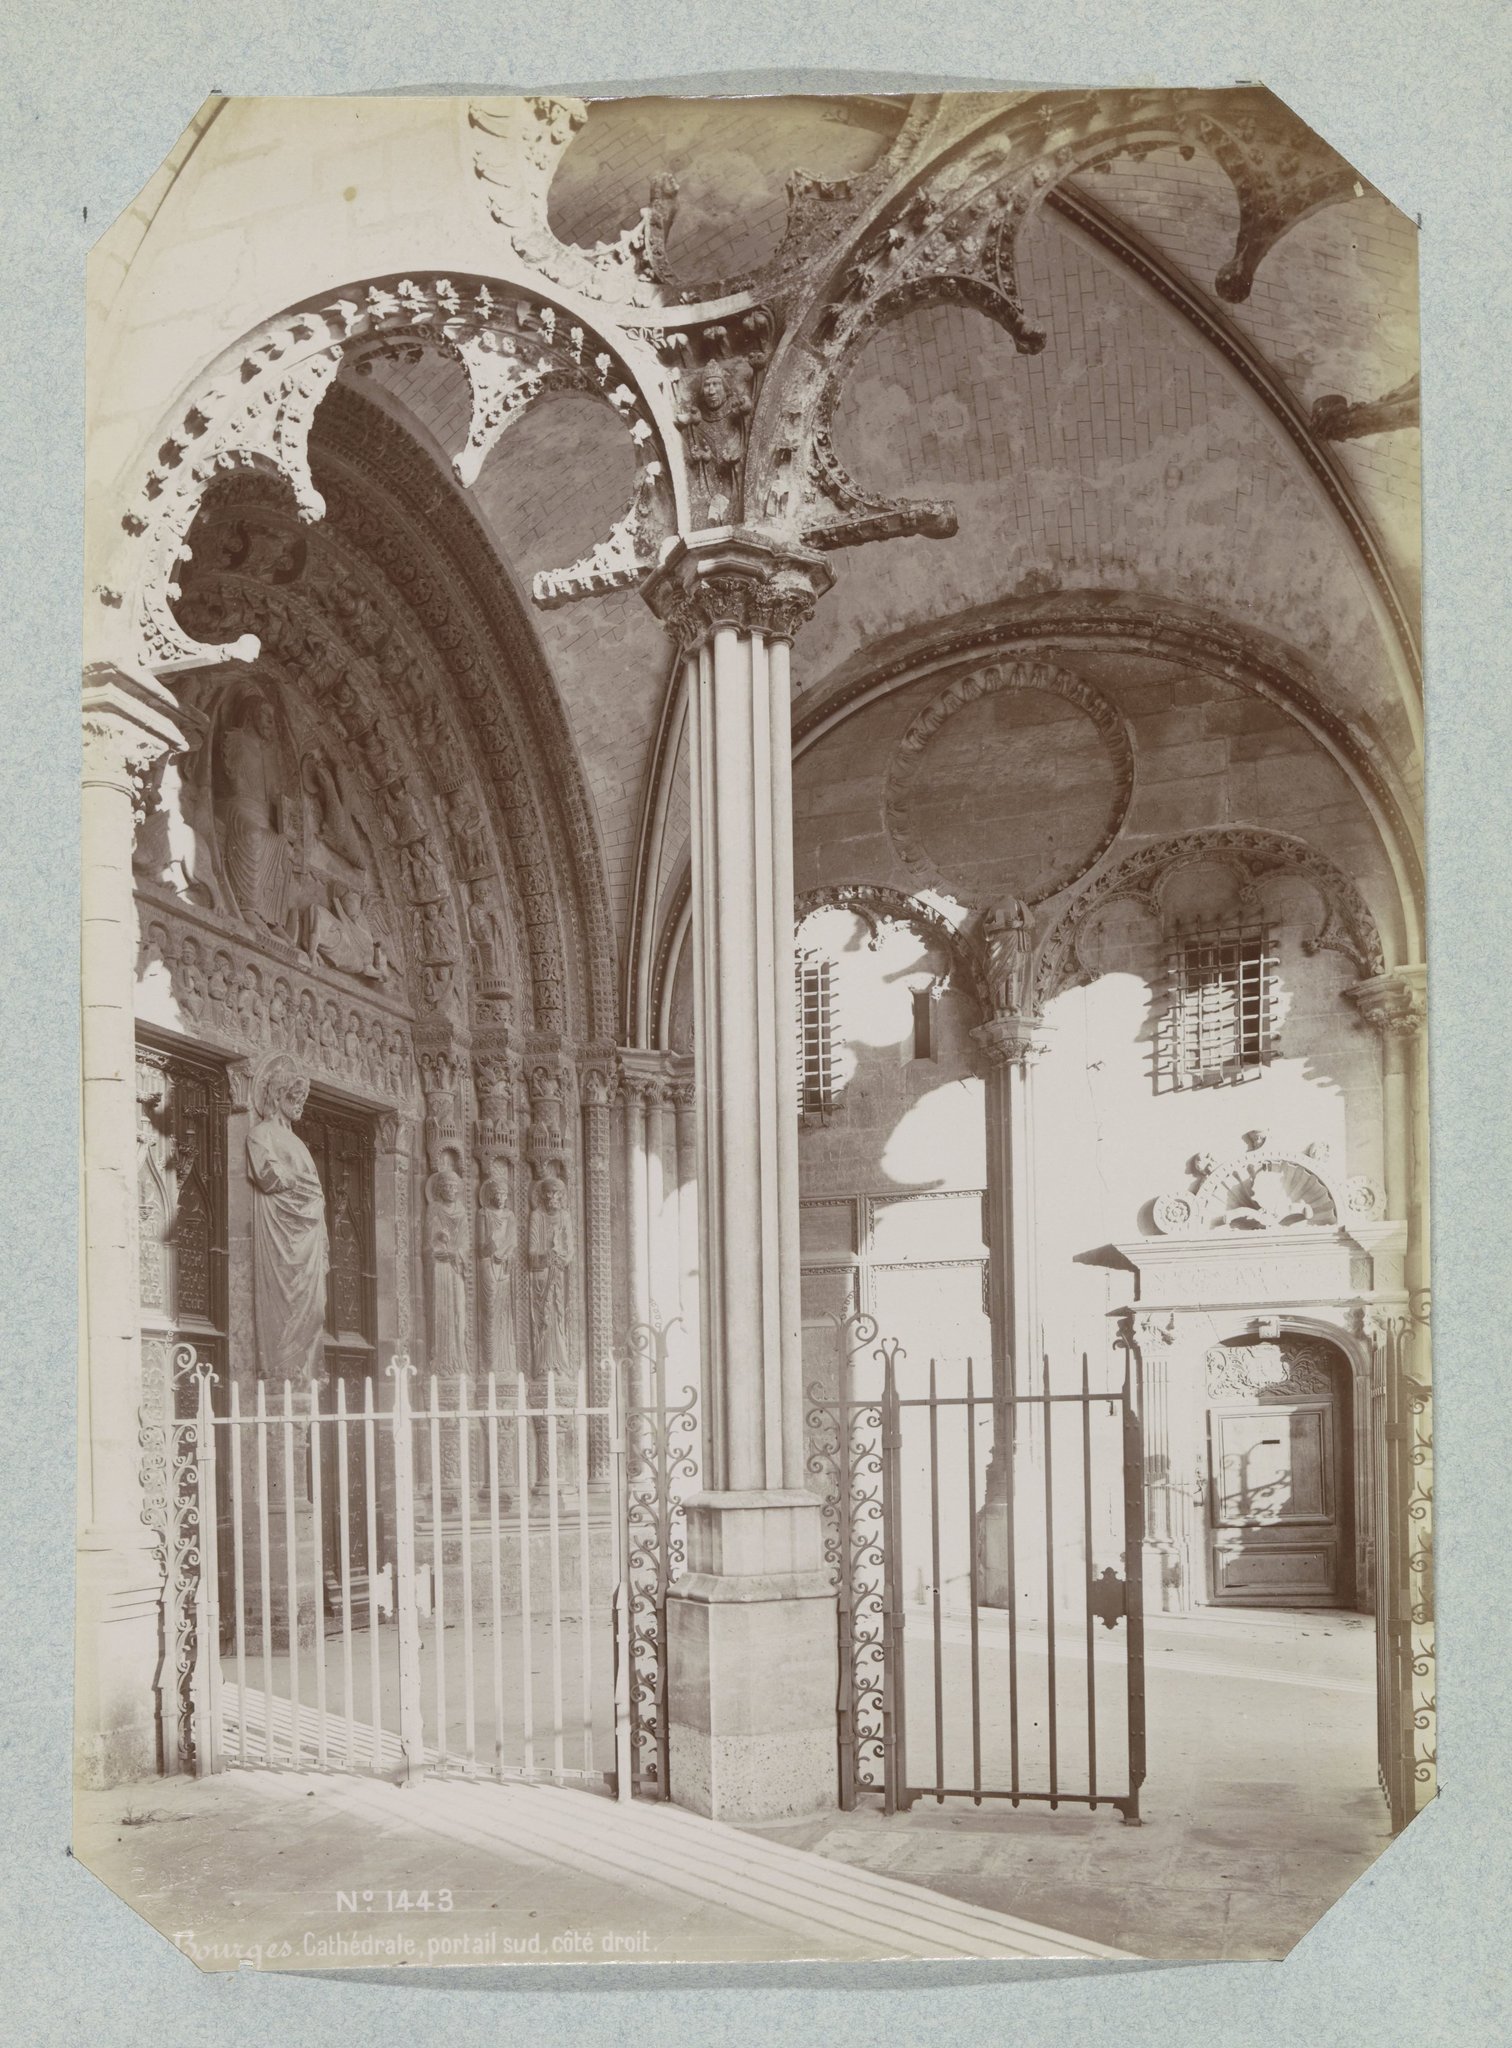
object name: photograph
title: Bourges. Cathédrale, portail sud, côté droit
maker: paul robert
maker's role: fotograaf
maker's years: 1865-1905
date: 1880-1900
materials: photographic support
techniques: albumen print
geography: bourges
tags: parts of church exterior and annexes: portal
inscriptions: inscription: ‘Monuments Historiques’, number: ‘1443’, name: ‘Paul Robert Paris’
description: Onderdeel van Fotoalbum met opnames van monumenten in Frankrijk.